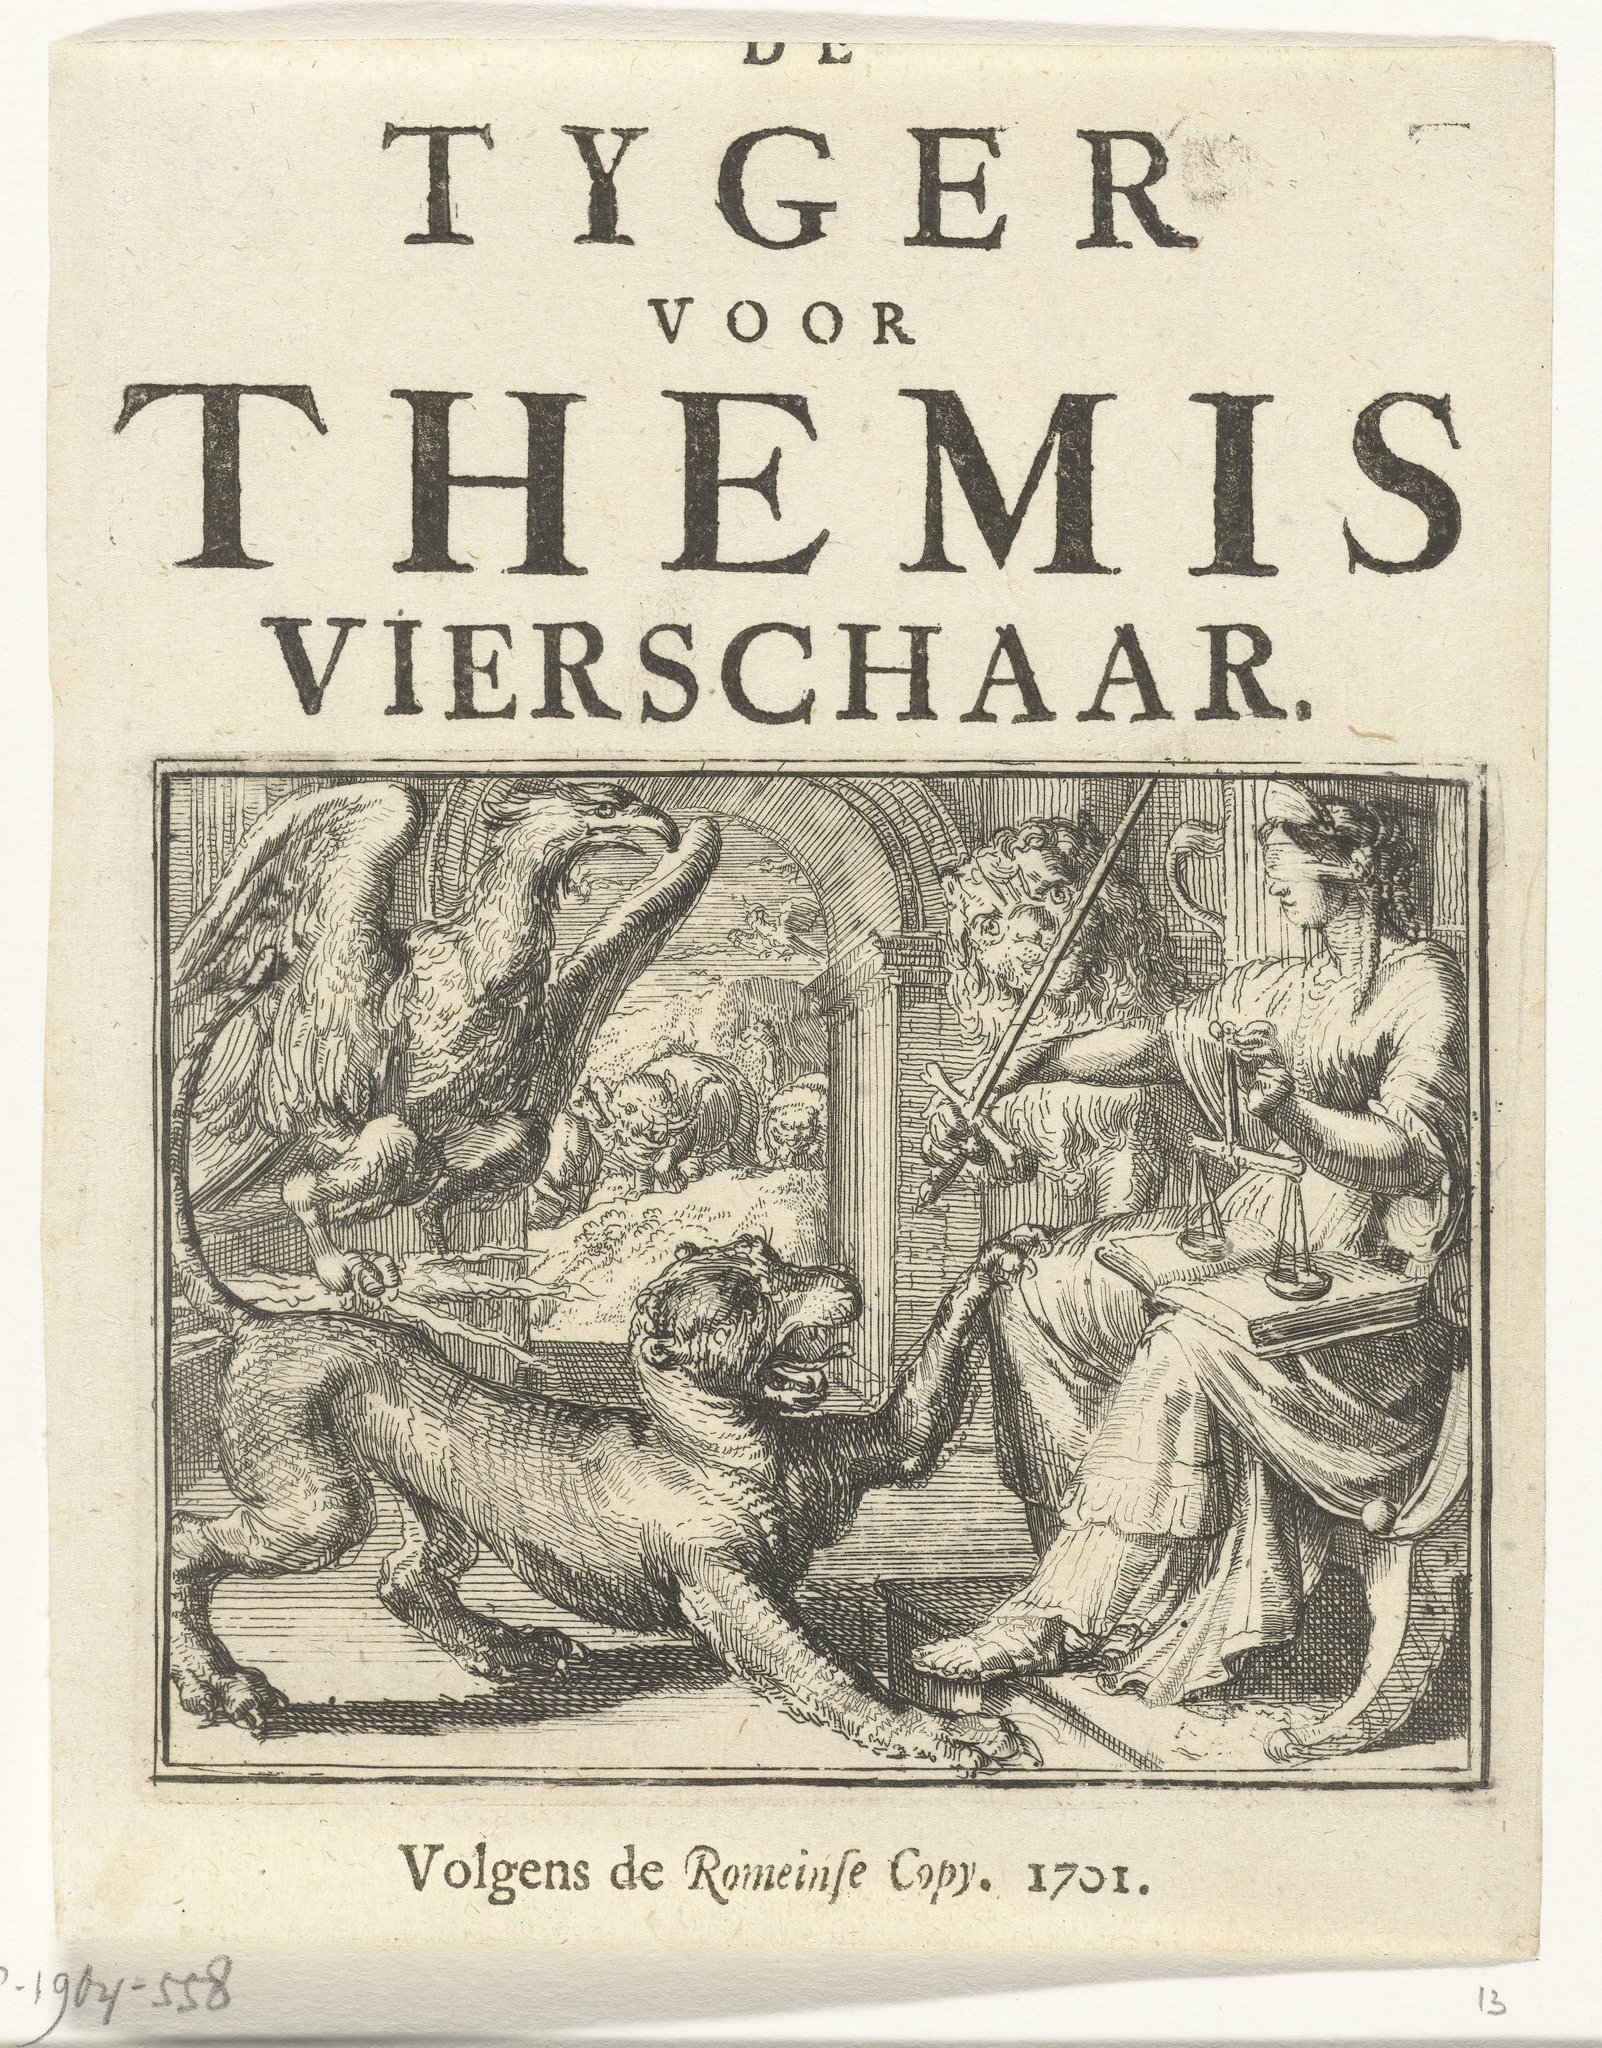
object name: print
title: De Tyger voor Themis Vierschaar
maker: romeyn de hooghe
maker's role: draughtsman, goldsmith, painter, print maker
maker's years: 1645-1708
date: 1701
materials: paper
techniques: etching, letterpress printing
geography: northern netherlands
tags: justice, 'justitia'; 'giustitia divina' (ripa) ~ one of the four cardinal virtues, themis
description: Titelblad voor het pamflet: De Tyger voor Themis Vierschaar, 1701. De tijger (Frankrijk) en de adelaar (Keizerrijk) voor Justitia / Themis. Spotprent op de aanhoudende Franse bemoeienis met de Spaanse erfopvolging.